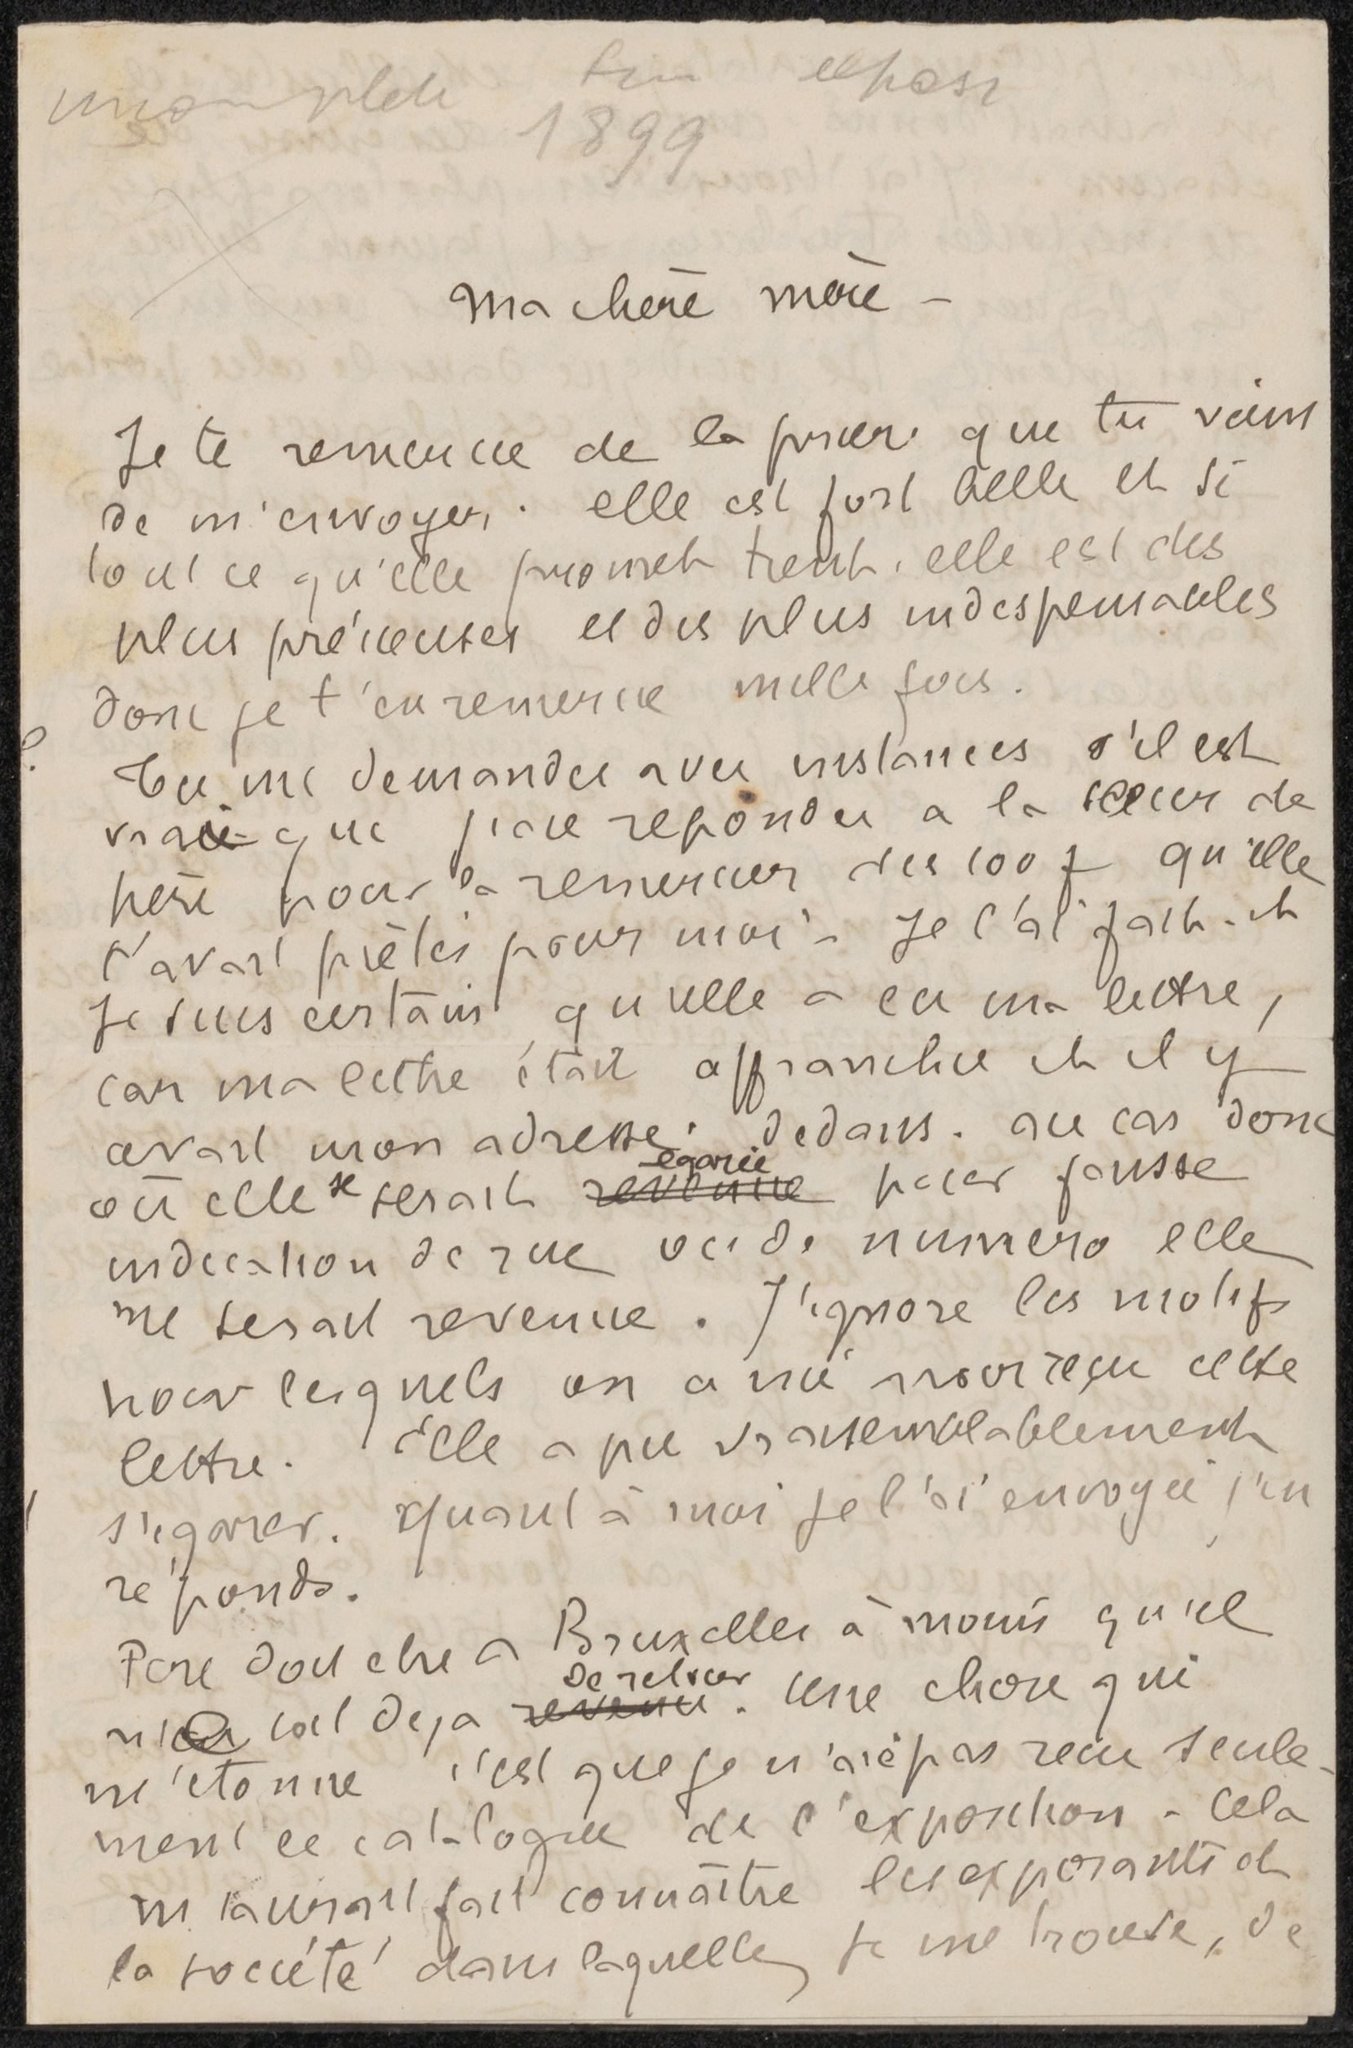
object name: letter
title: Brief aan Héloïse Bernard-Bodin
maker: émile bernard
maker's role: print maker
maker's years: 1868-1941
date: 1878-1941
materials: ink, paper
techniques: pen, writing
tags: héloïse bernard-bodin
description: Brief gedateerd fin 1899 in latere hand.